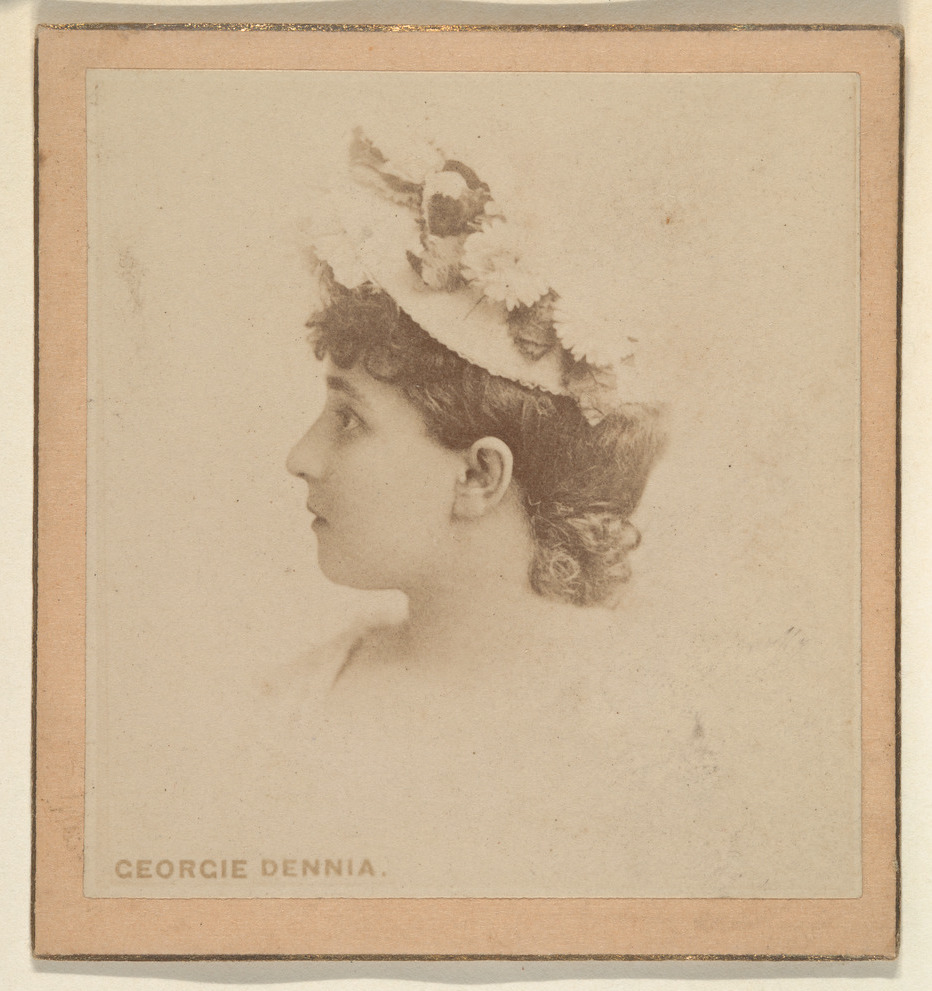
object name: photograph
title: Georgie Dennia, from the Actresses series (N246), Type 2, issued by Kinney Brothers to promote Sporting Extra Cigarettes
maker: kinney brothers tobacco company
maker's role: publisher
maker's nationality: american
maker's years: 1869-2011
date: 1890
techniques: albumen silver print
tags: women,actresses